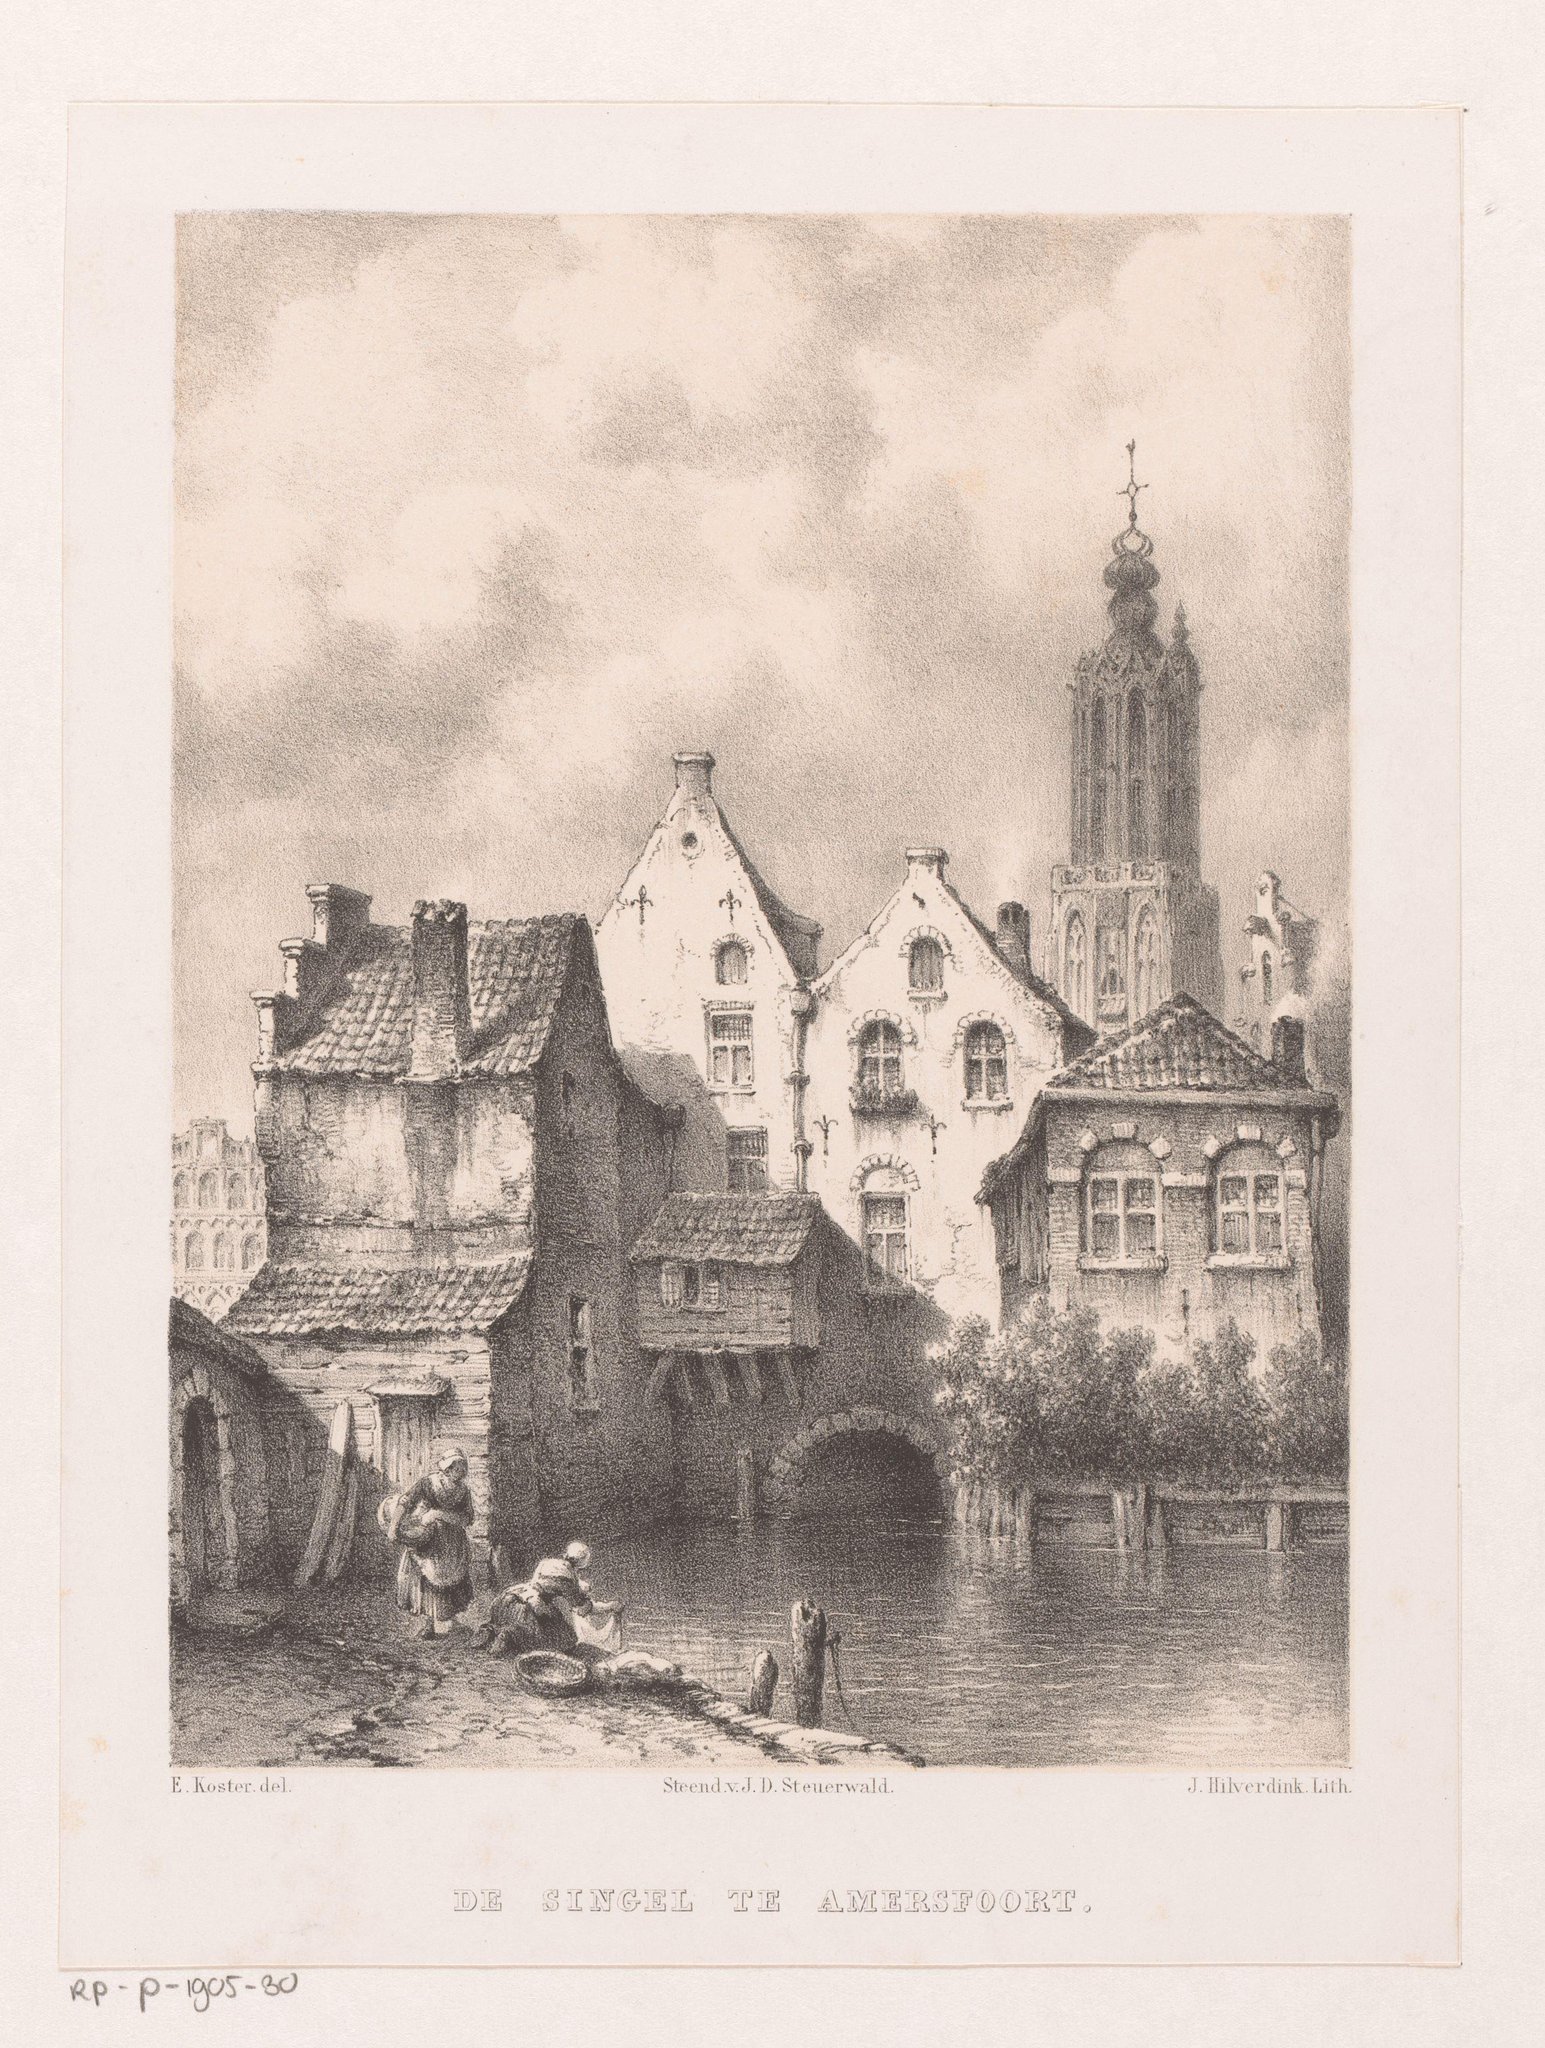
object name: print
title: De Singel te Amersfoort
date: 1858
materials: paper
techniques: tone lithography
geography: amsterdam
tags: laundering, canals, waters (in city), city-view, and landscape with man-made constructions (+ city(-scape) with figures, staffage)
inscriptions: collector's mark: Lugt 2228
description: Deze prent komt uit: Koster, E. 'E. Koster's schetsboek: Nederlandsche Stads- en Havengezichten, uitgegeven onder medewerking van de maatschappij Arti et Amicitiae, Amsterdam, F. Buffa en Zn., e.a.' Amsterdam 1858.